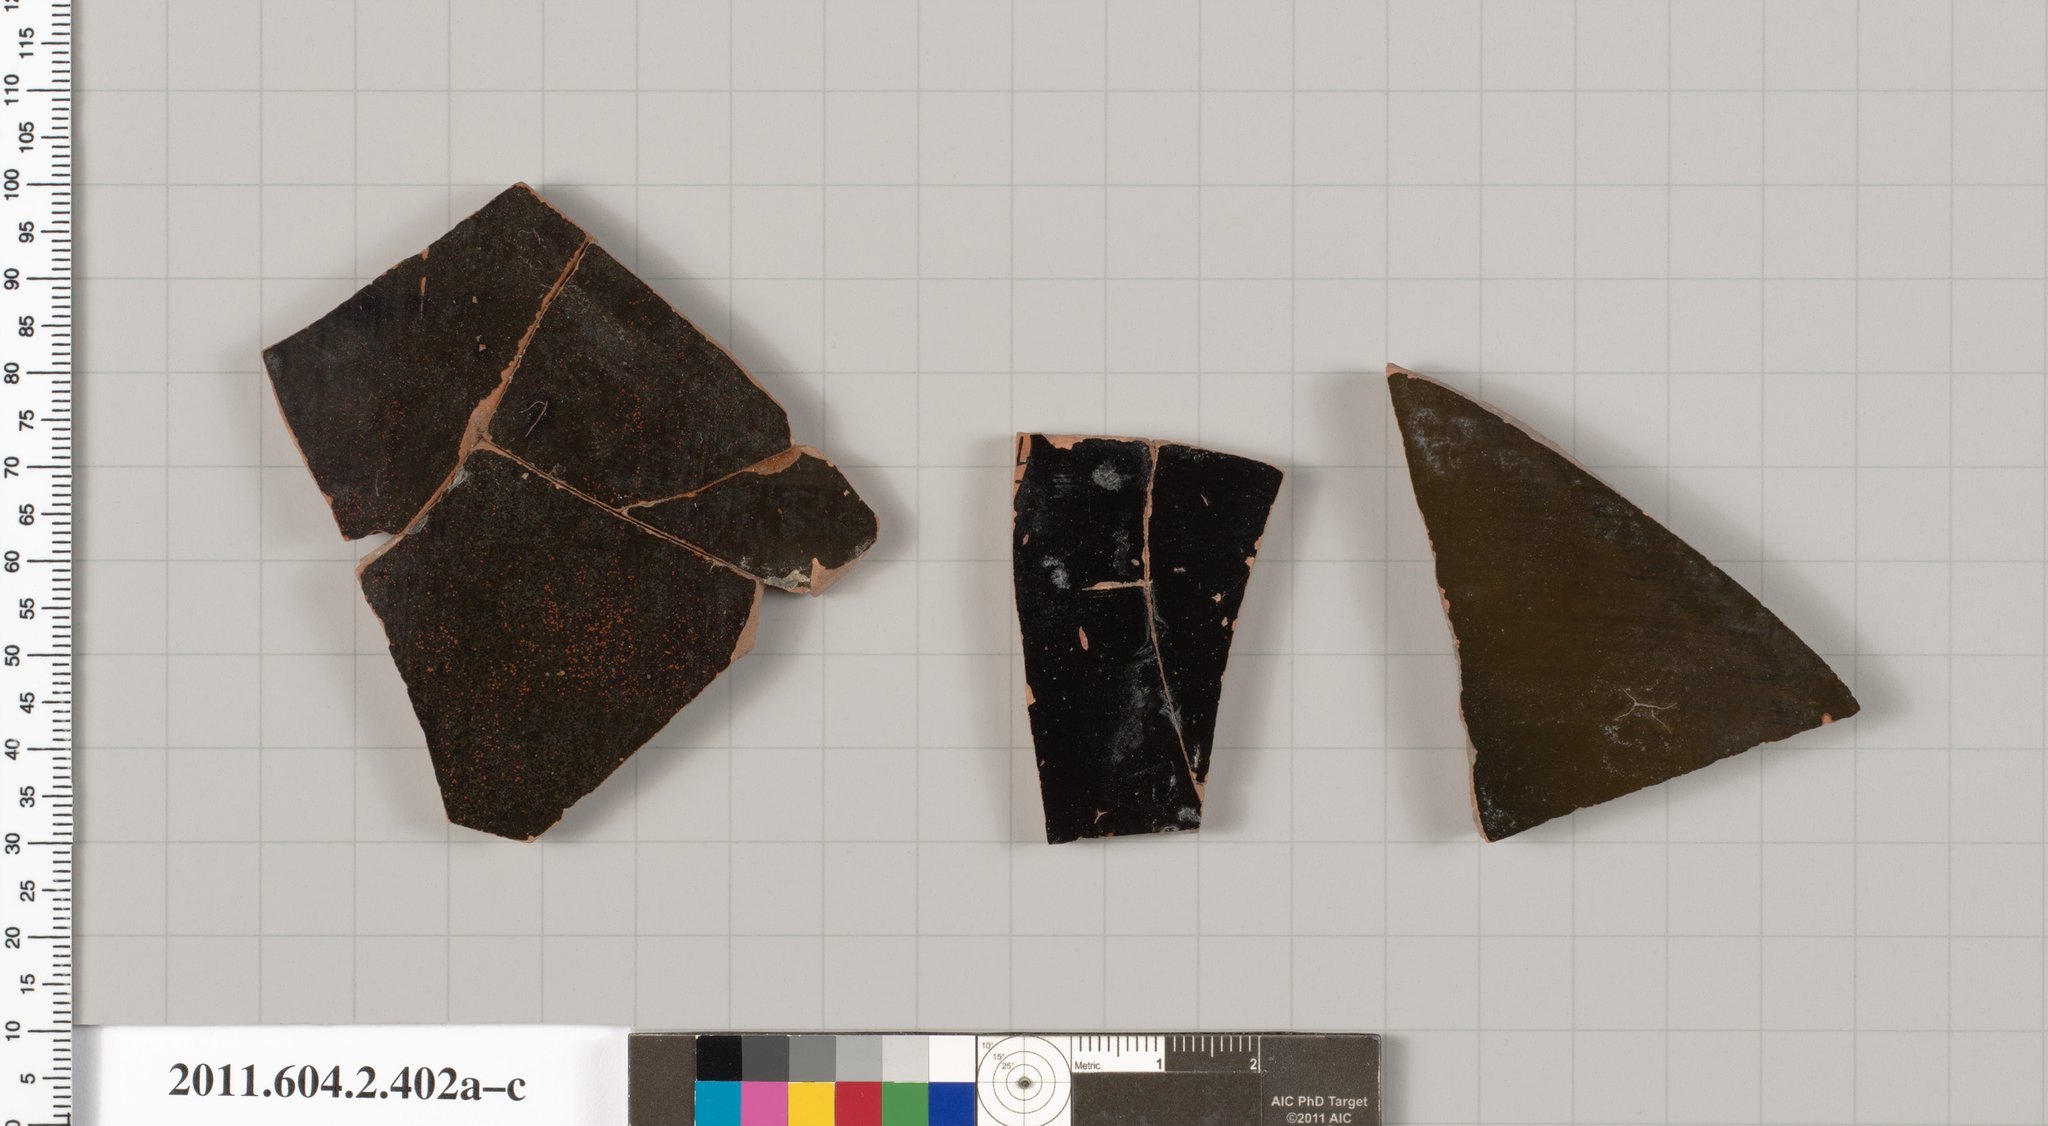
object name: column krater fragment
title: Terracotta fragments of column-kraters (bowls for mixing wine and water)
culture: greek, attic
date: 401-500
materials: terracotta